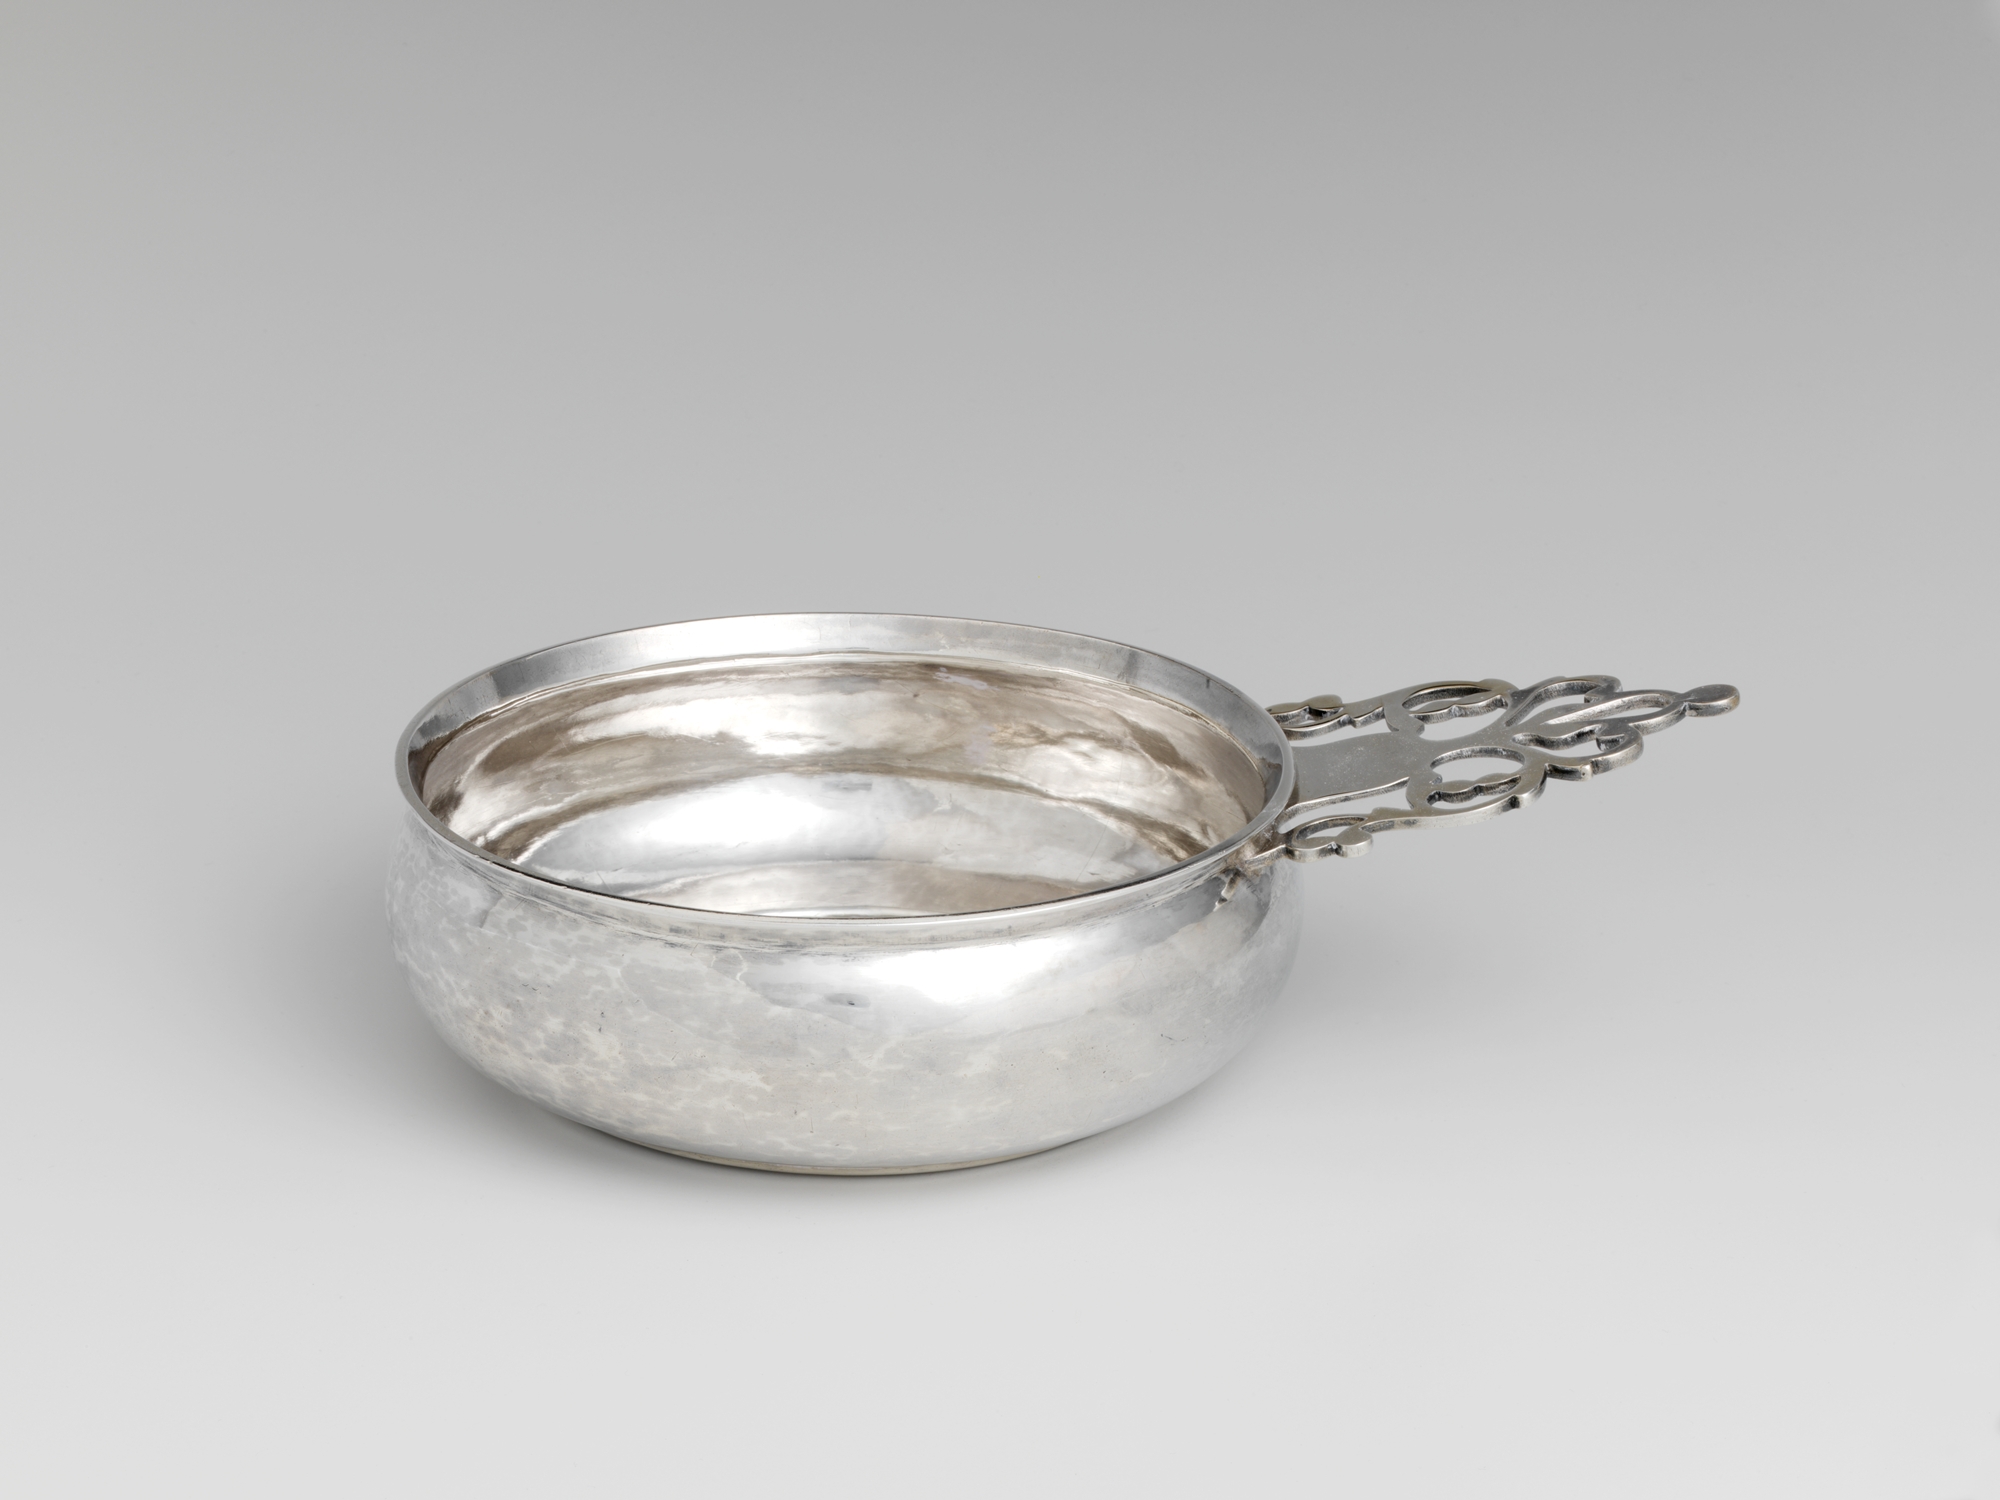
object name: porringer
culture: american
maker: benjamin brenton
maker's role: maker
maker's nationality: american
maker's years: 1710-1766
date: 1730-1747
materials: silver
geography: united states